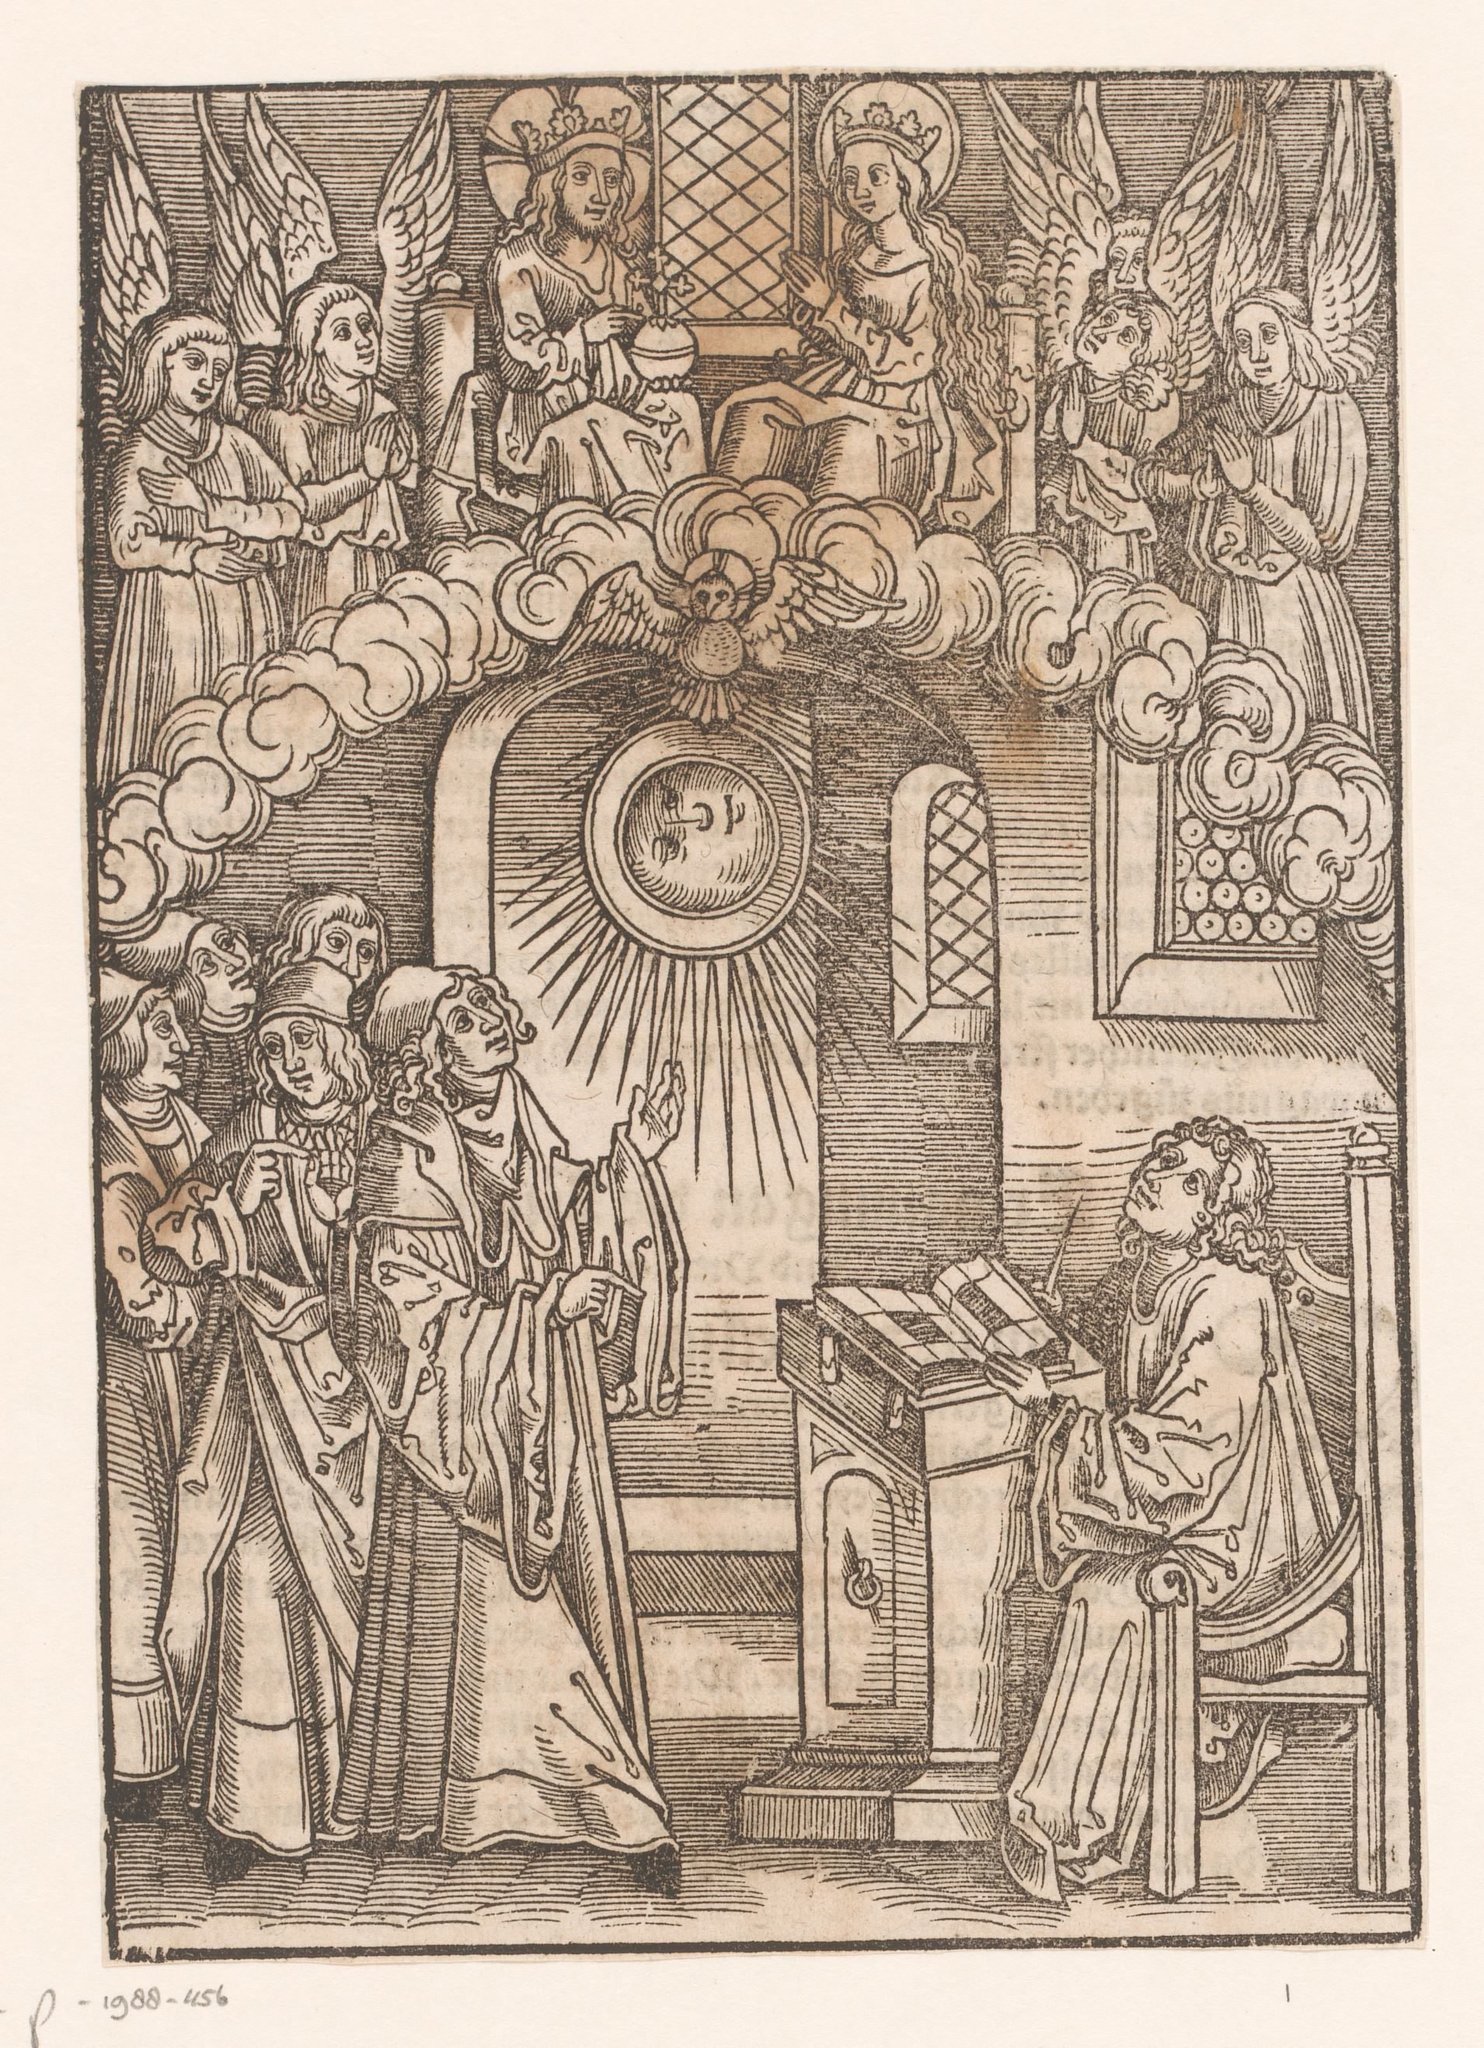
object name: print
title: Schrijver in zijn werkkamer ziet Christus en Maria omgeven door engelen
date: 1518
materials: paper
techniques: woodcut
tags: christian religion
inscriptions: collector's mark: Lugt 2228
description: Prent voor het eerst gebruikt in: Tengler, Ulrich. Neü Layenspiegel. Straatsburg: Matthias Hupfuff, 1518.